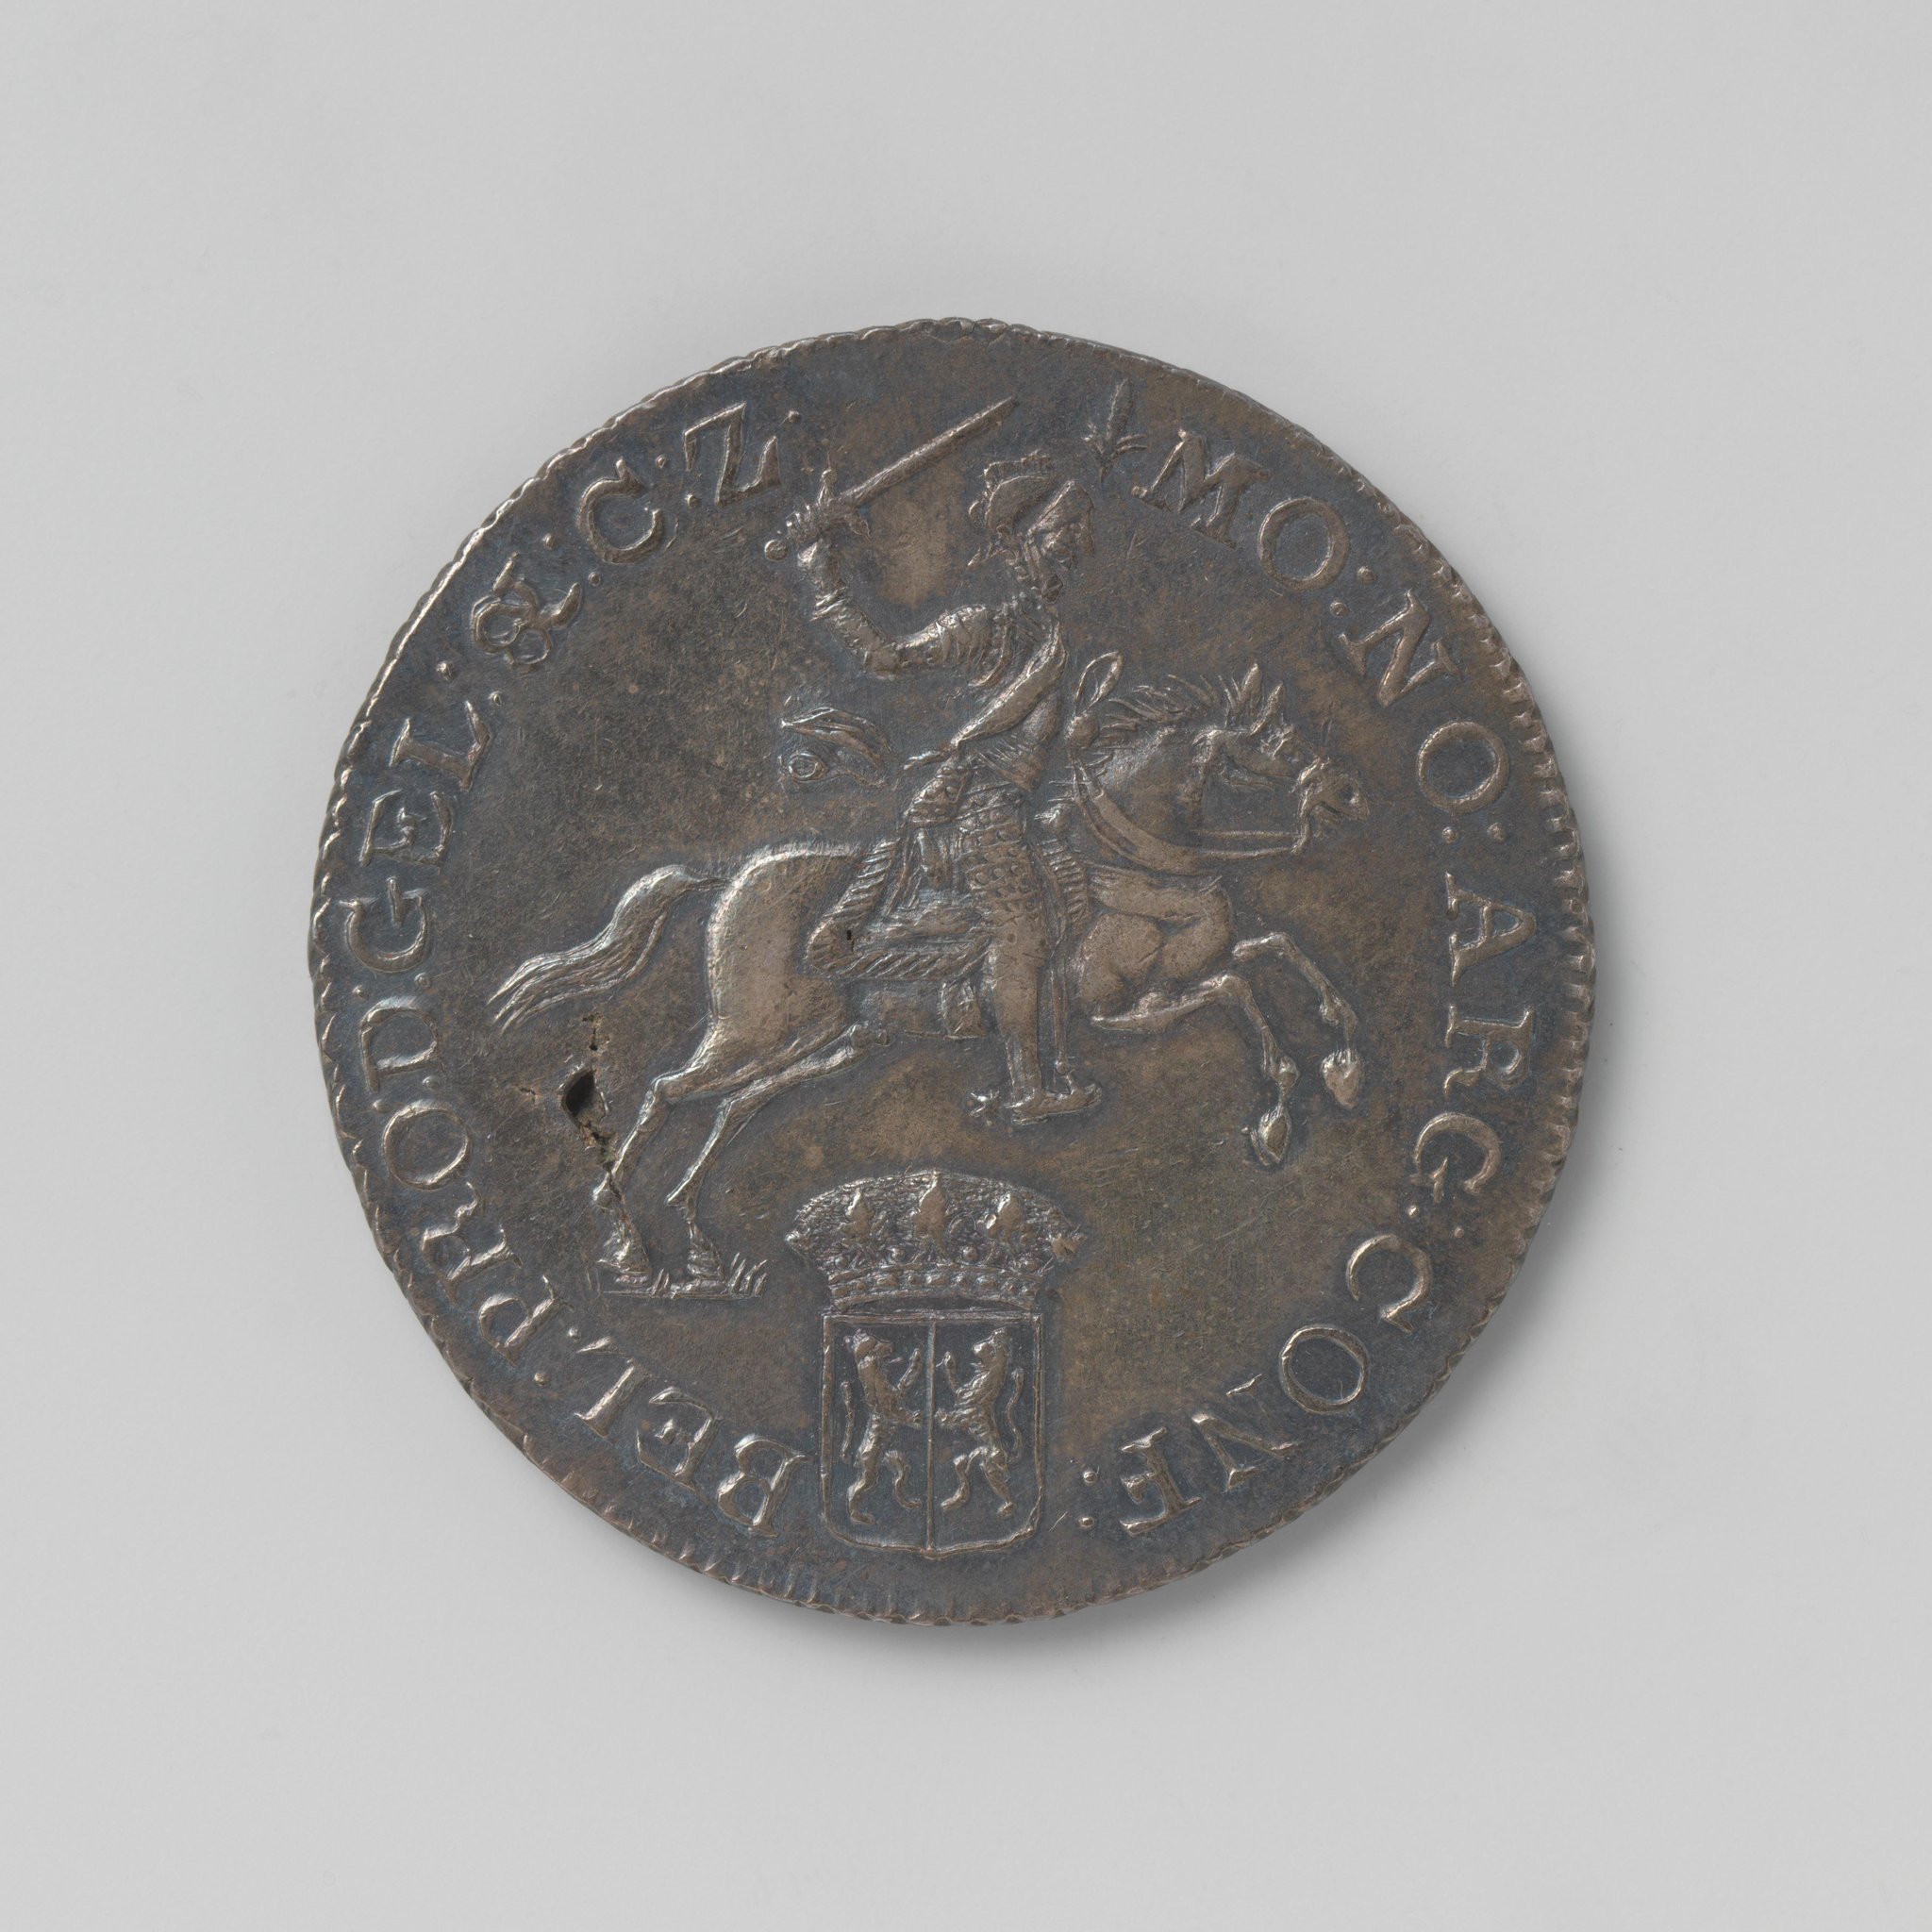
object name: coin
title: Gelderse zilveren rijder, 1792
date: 1792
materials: silver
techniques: striking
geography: harderwijk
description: Zilveren munt. Voorzijde: ruiter met zwaard naar rechts. Daaronder gekroond Gelders wapenschild. Keerzijde: door twee leeuwen gehouden gekroond generaliteitswapenschild. Daaronder cartouche, waarin jaartal.